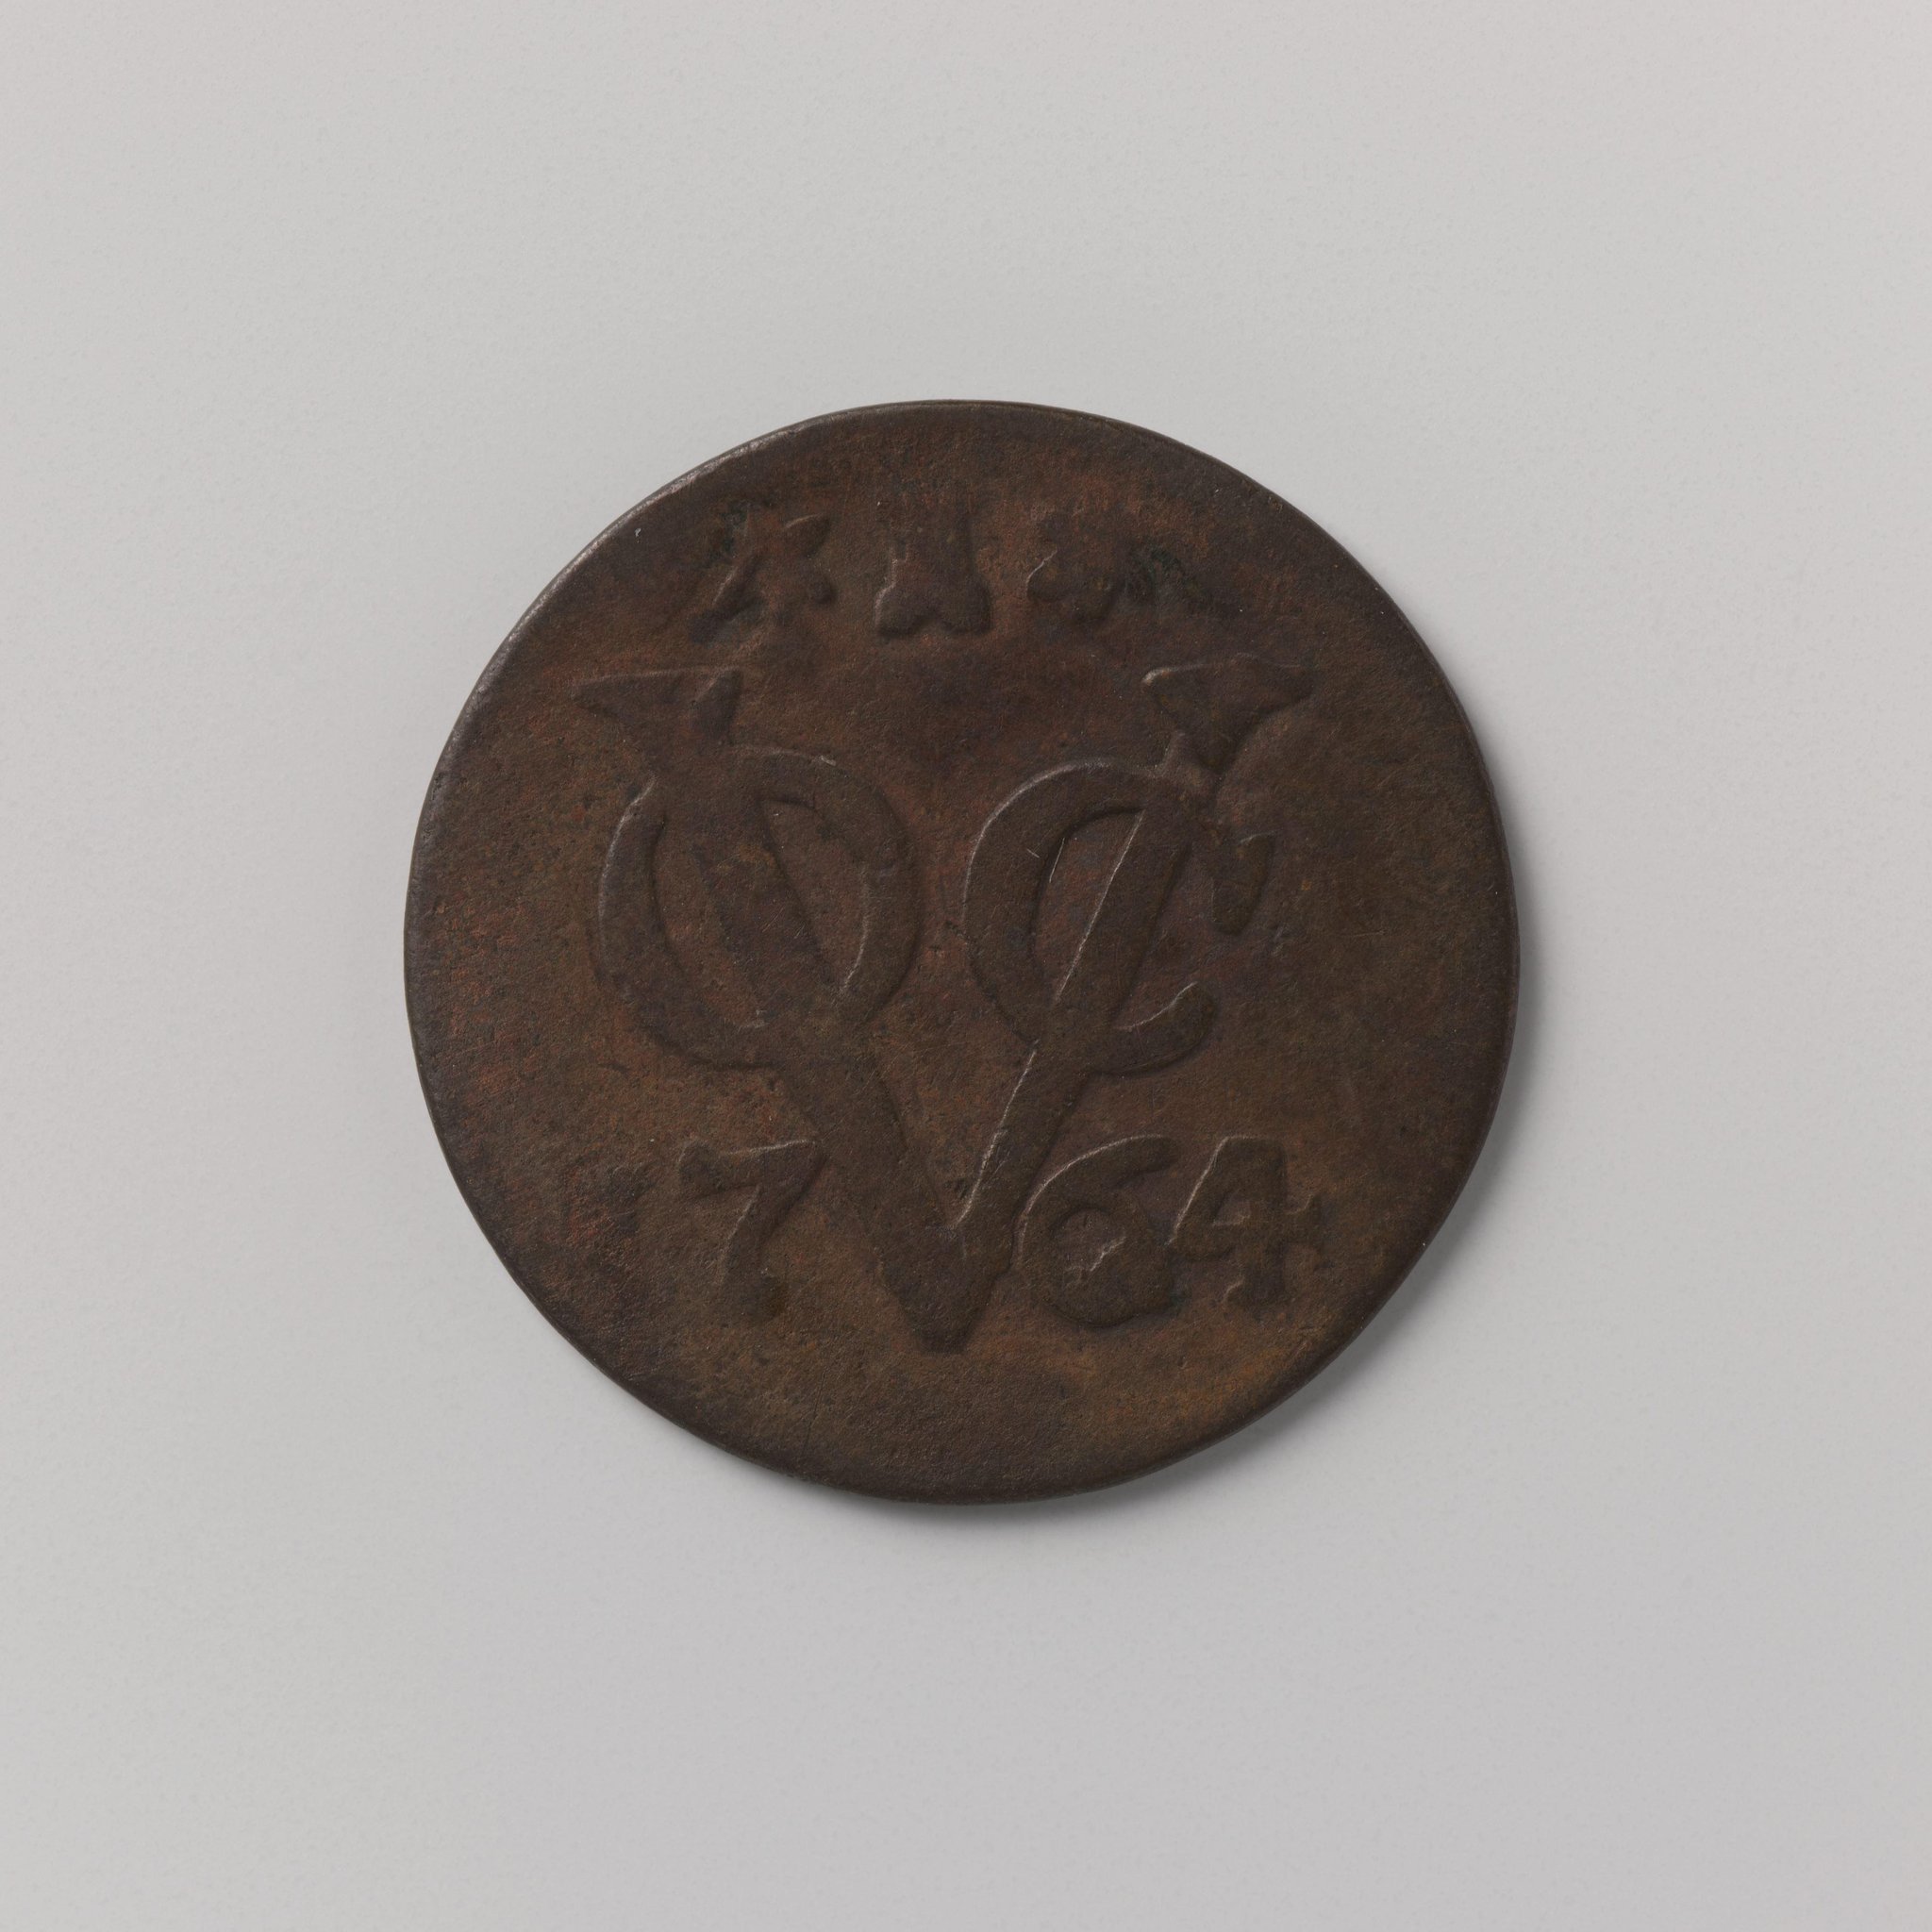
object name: coin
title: VOC, duit Zeeland, 1764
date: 1764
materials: copper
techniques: striking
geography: middelburg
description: Koperen munt. Voorzijde: gekroond wapenschild van Zeeland. Keerzijde: monogram van de VOC, waarboven muntteken en waaronder jaartal. Gladde rand.